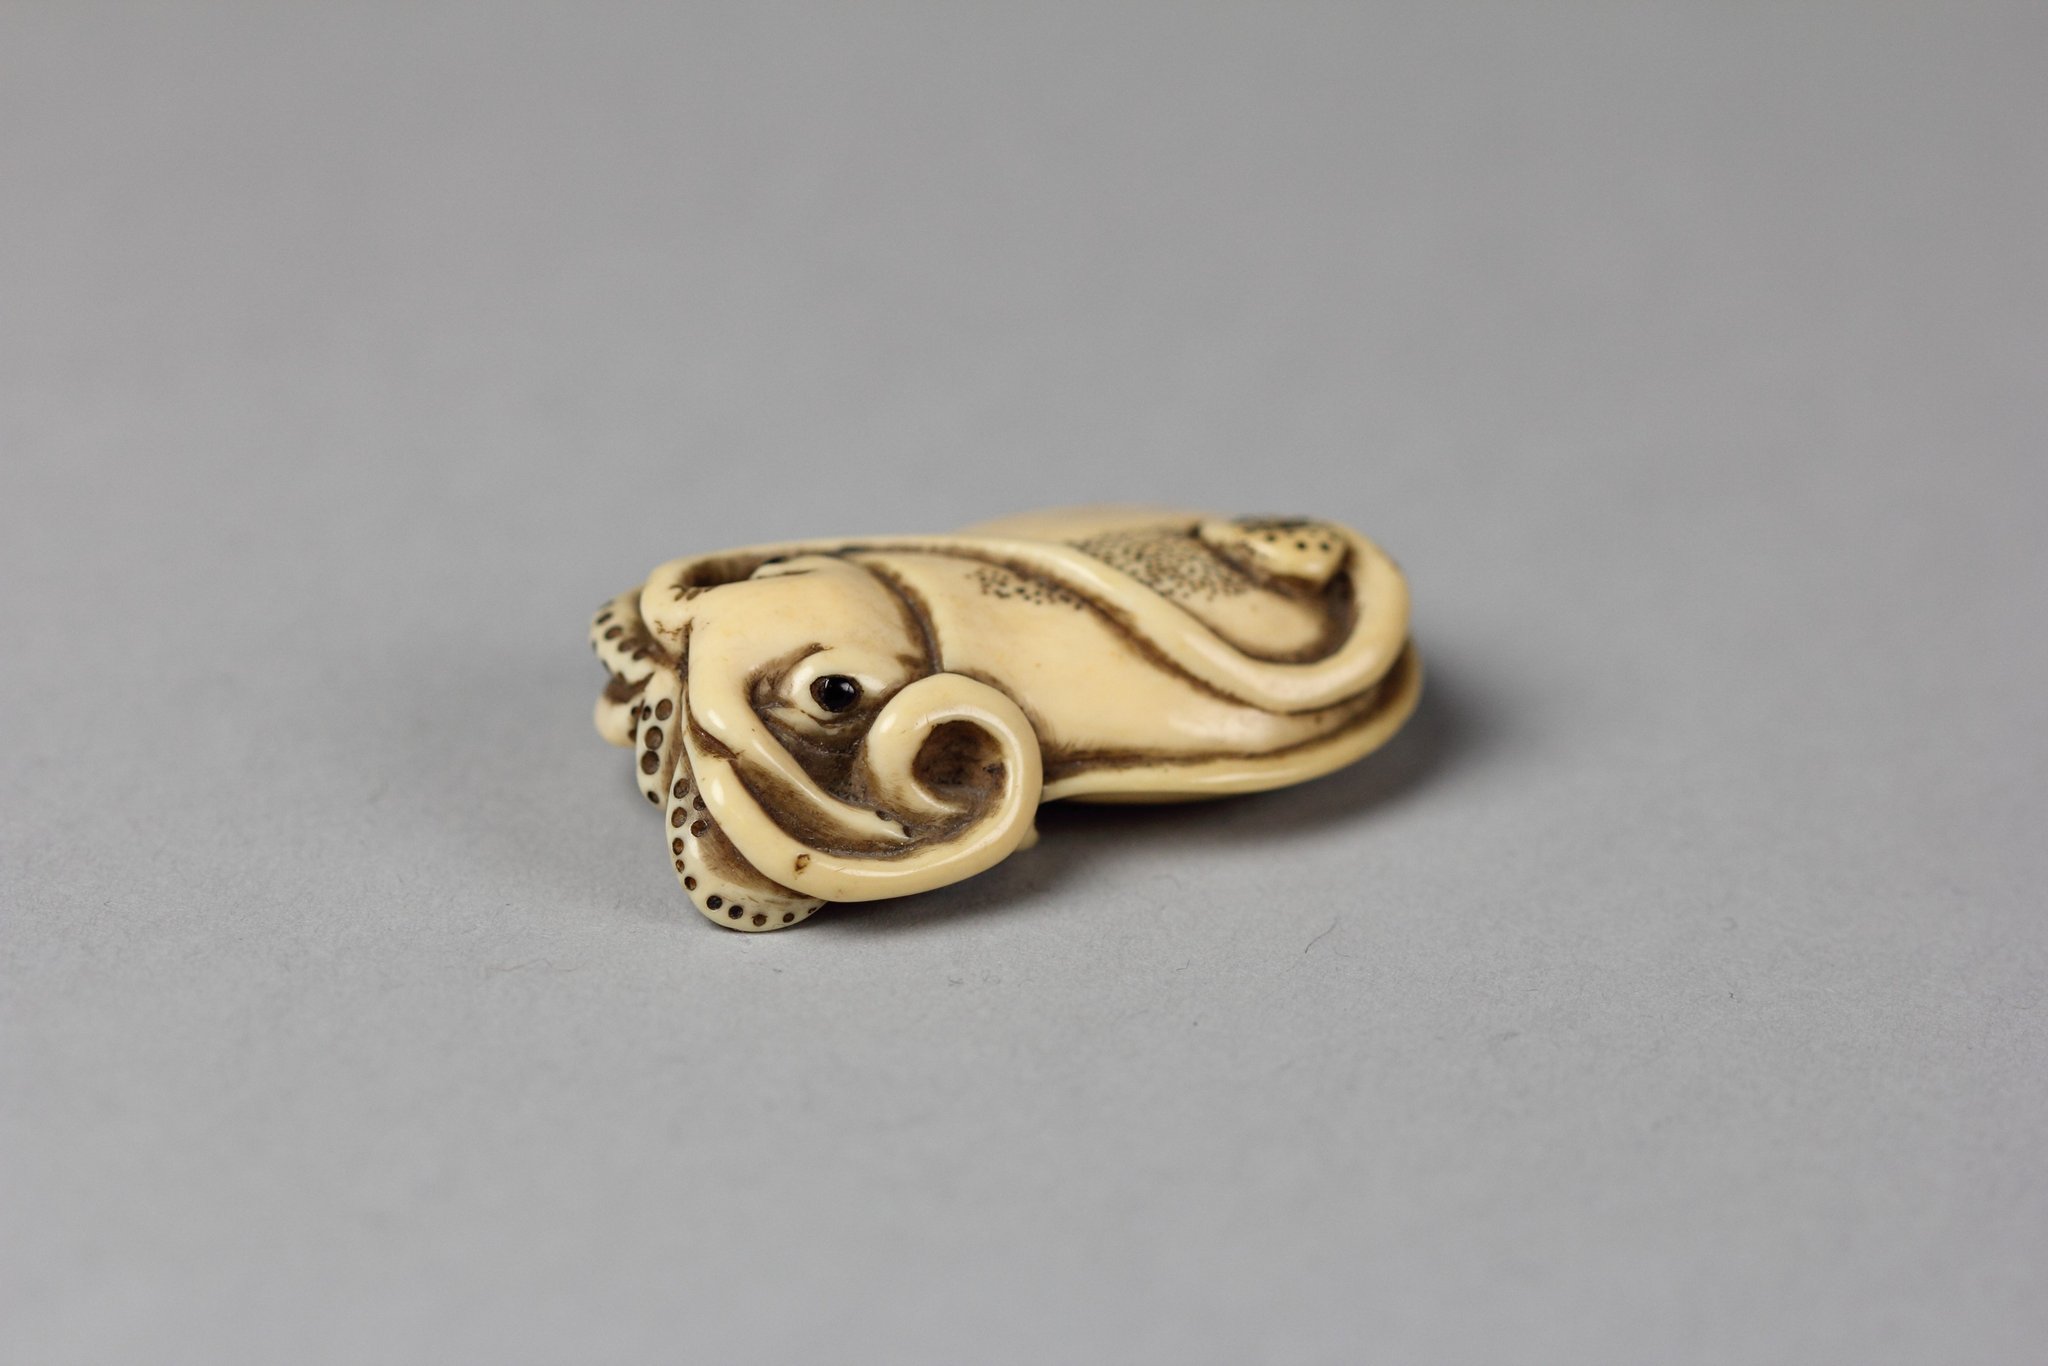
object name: netsuke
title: Netsuke of Octopus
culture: japanese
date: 1801-1900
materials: ivory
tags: octopus